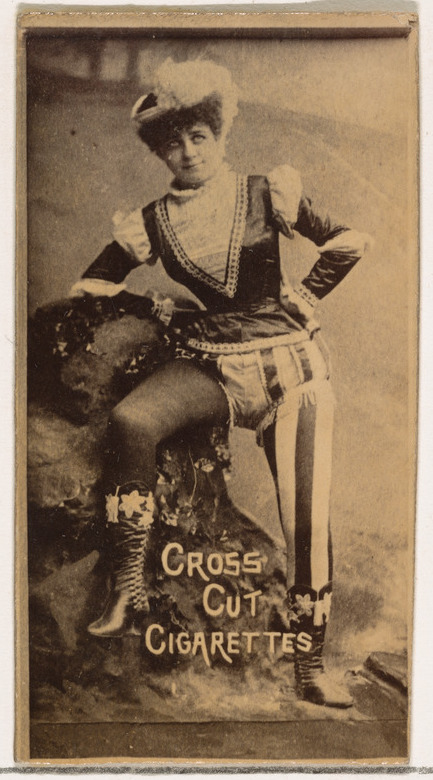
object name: print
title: Actress posing on pile of boulders, from the Actors and Actresses series (N145-1) issued by Duke Sons & Co. to promote Cross Cut Cigarettes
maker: w. duke, sons & co.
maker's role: publisher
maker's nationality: american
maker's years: 1870-1920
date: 1880-1889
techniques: albumen silver print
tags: portraits,women,actresses